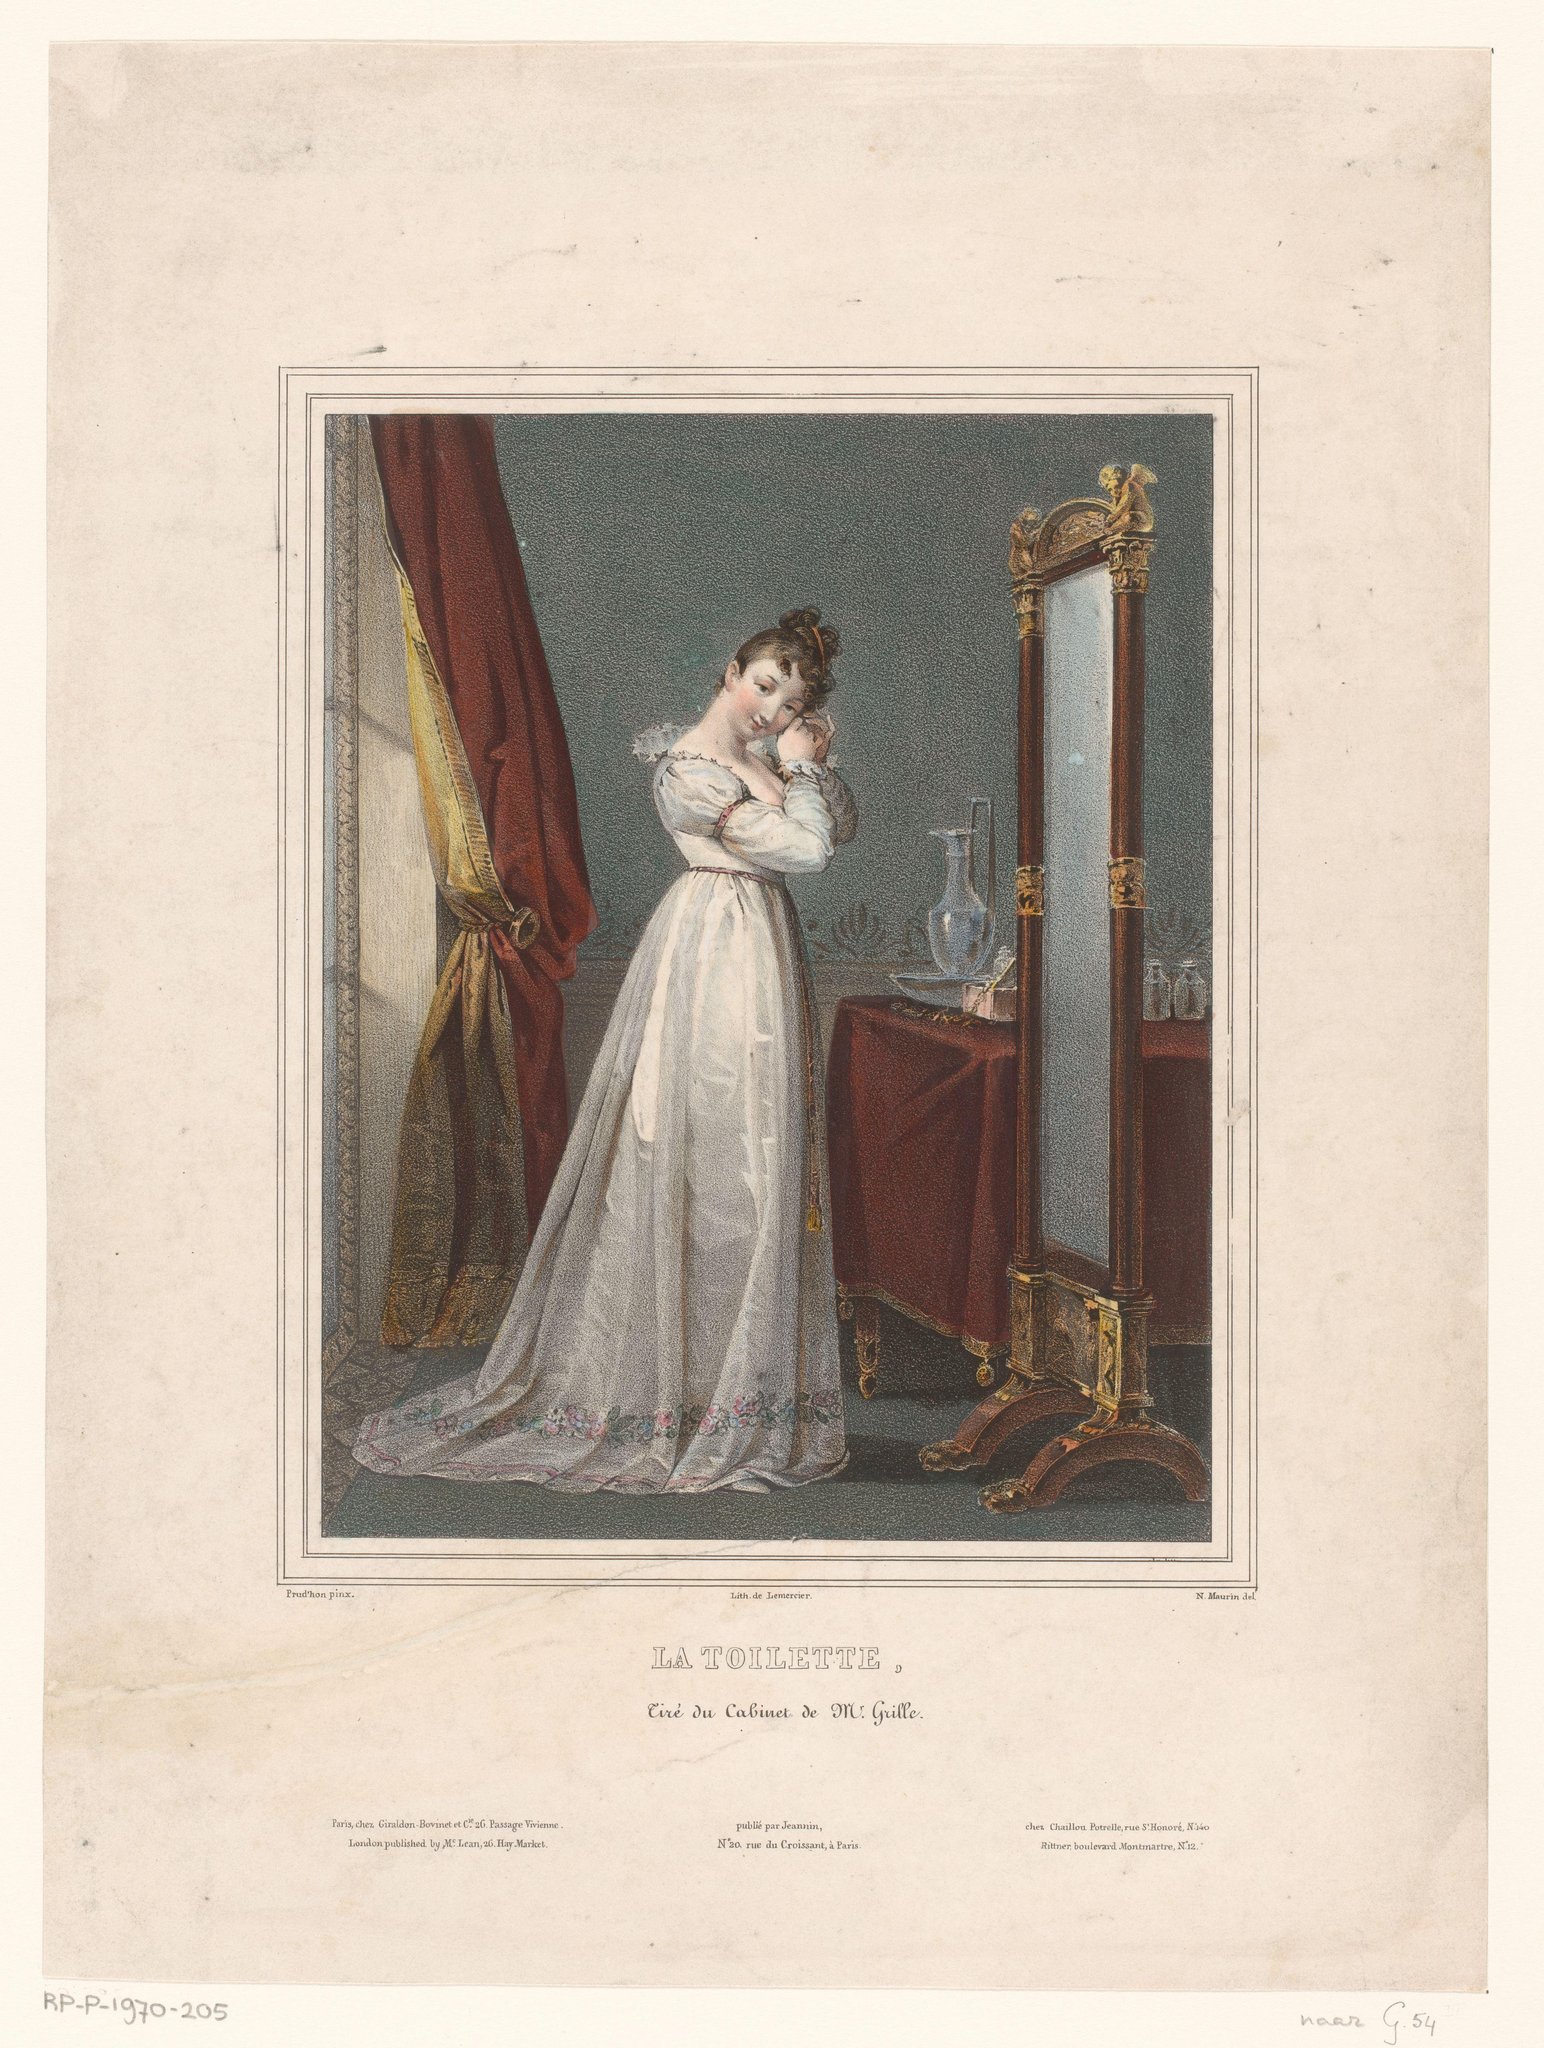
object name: print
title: Jonge vrouw staand voor spiegel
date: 1815-1850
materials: paper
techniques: hand coloring, lithograph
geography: paris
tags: making toilet - aa - (for) women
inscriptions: collector's mark: Lugt 2228, collector's mark: Lugt 2760